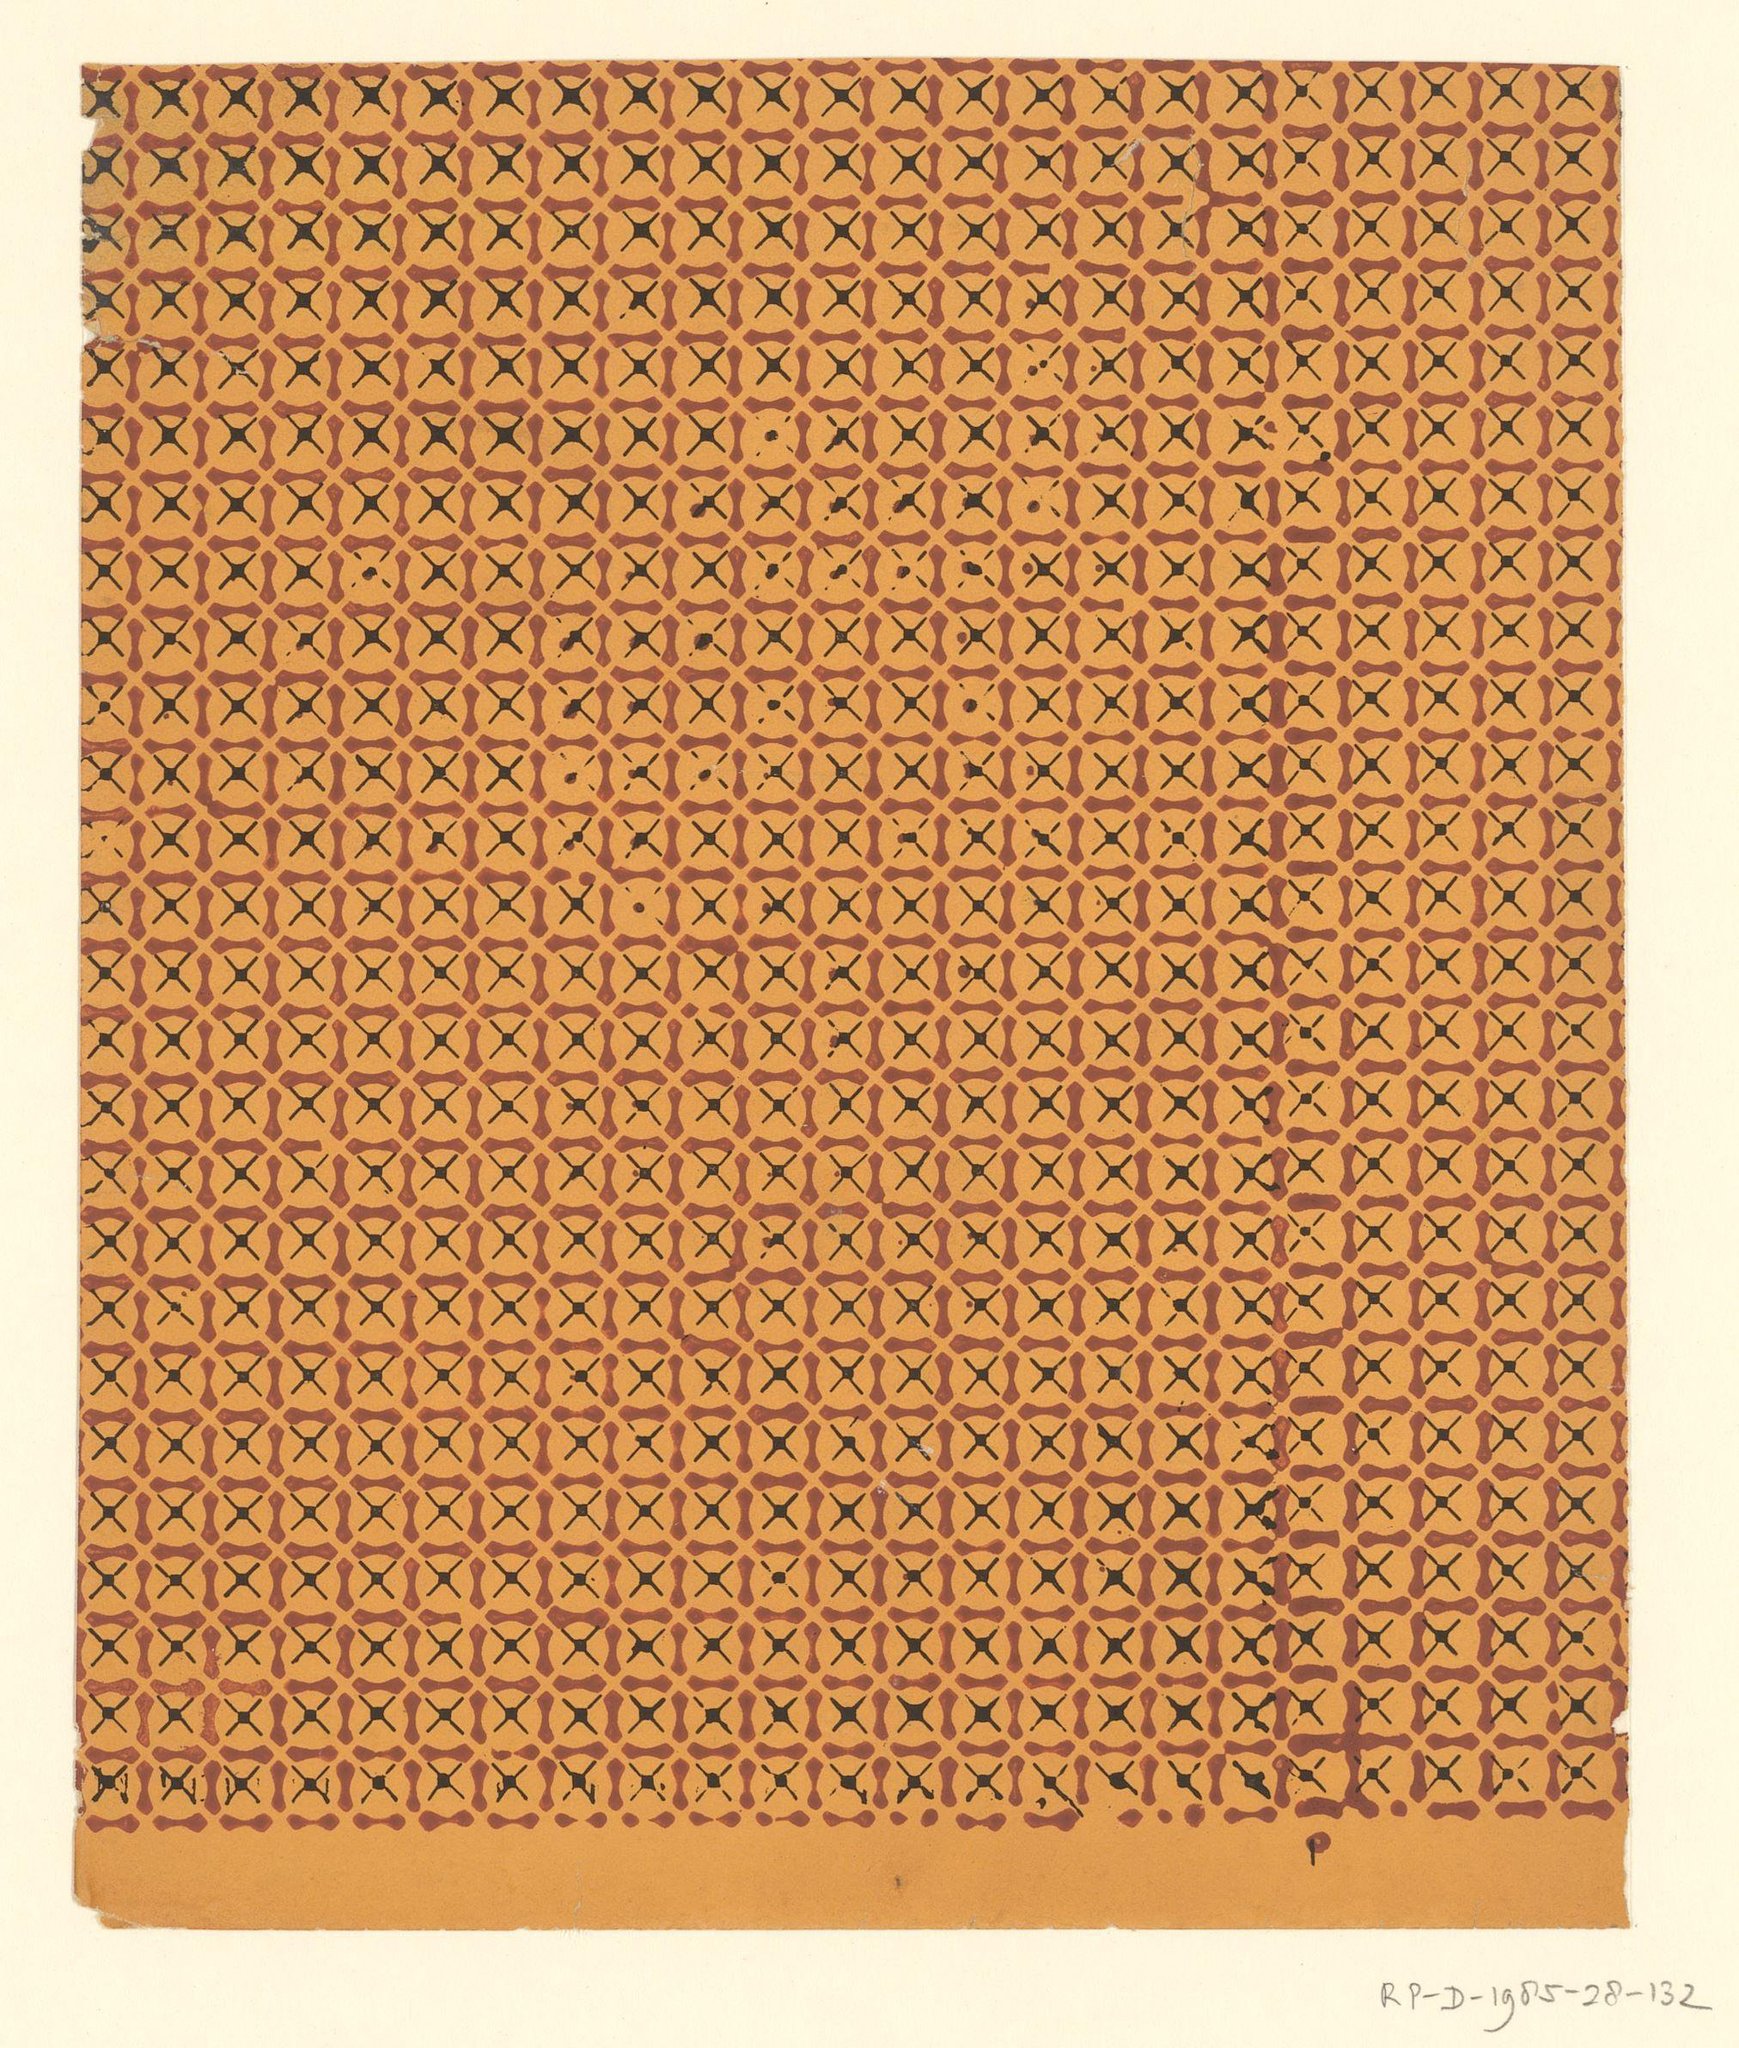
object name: printed paper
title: Blad met rasterpatroon met zwart kruismotief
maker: Anonymous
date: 1750-1900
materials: paper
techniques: printing block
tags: ornament ~ geometric motifs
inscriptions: collector's mark: Lugt 2760, collector's mark: Lugt 2228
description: Blad met rasterpatroon van cirkels gevuld met zwart kruismotief. Waarschijnlijk de helft van een omslag.